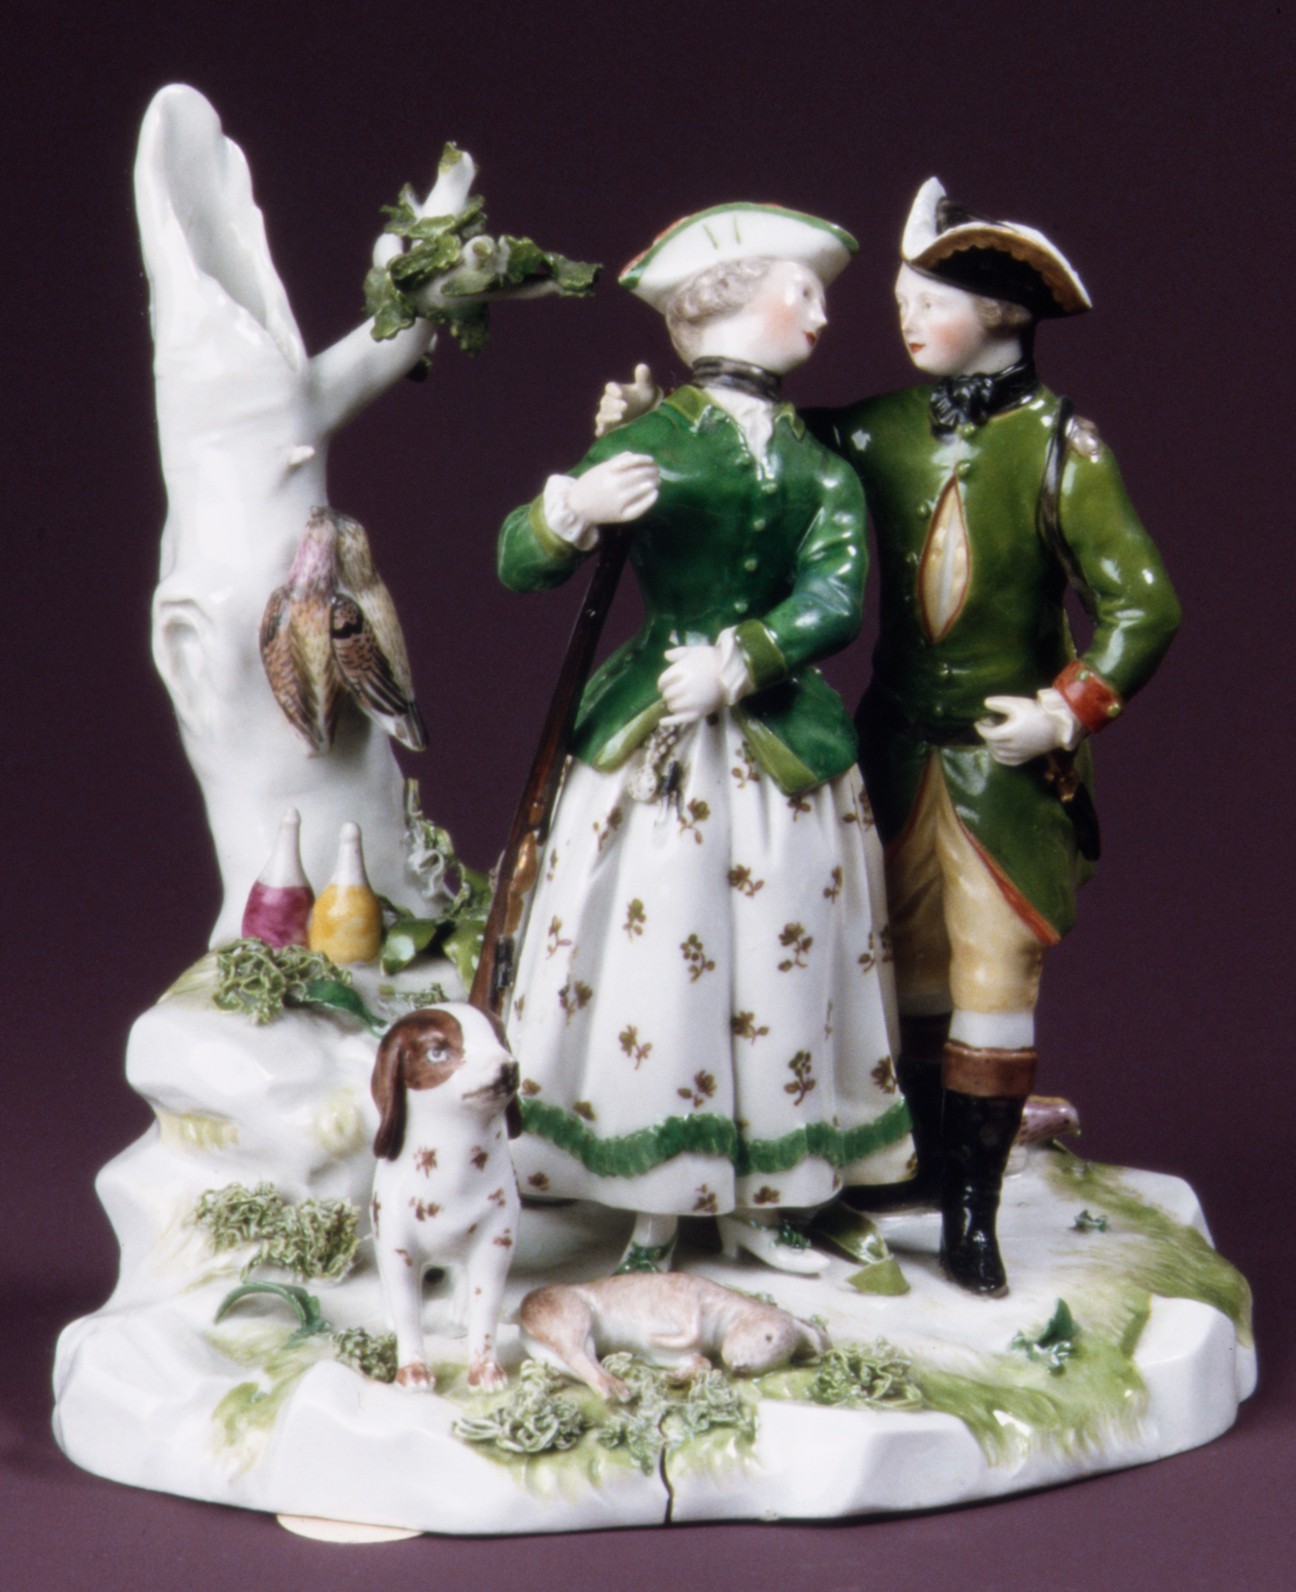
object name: group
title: Hunting Couple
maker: fulda pottery and porcelain manufactory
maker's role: manufactory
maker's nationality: german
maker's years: 1764-1789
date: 1775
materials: hard paste porcelain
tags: birds,firearms,couples,dogs